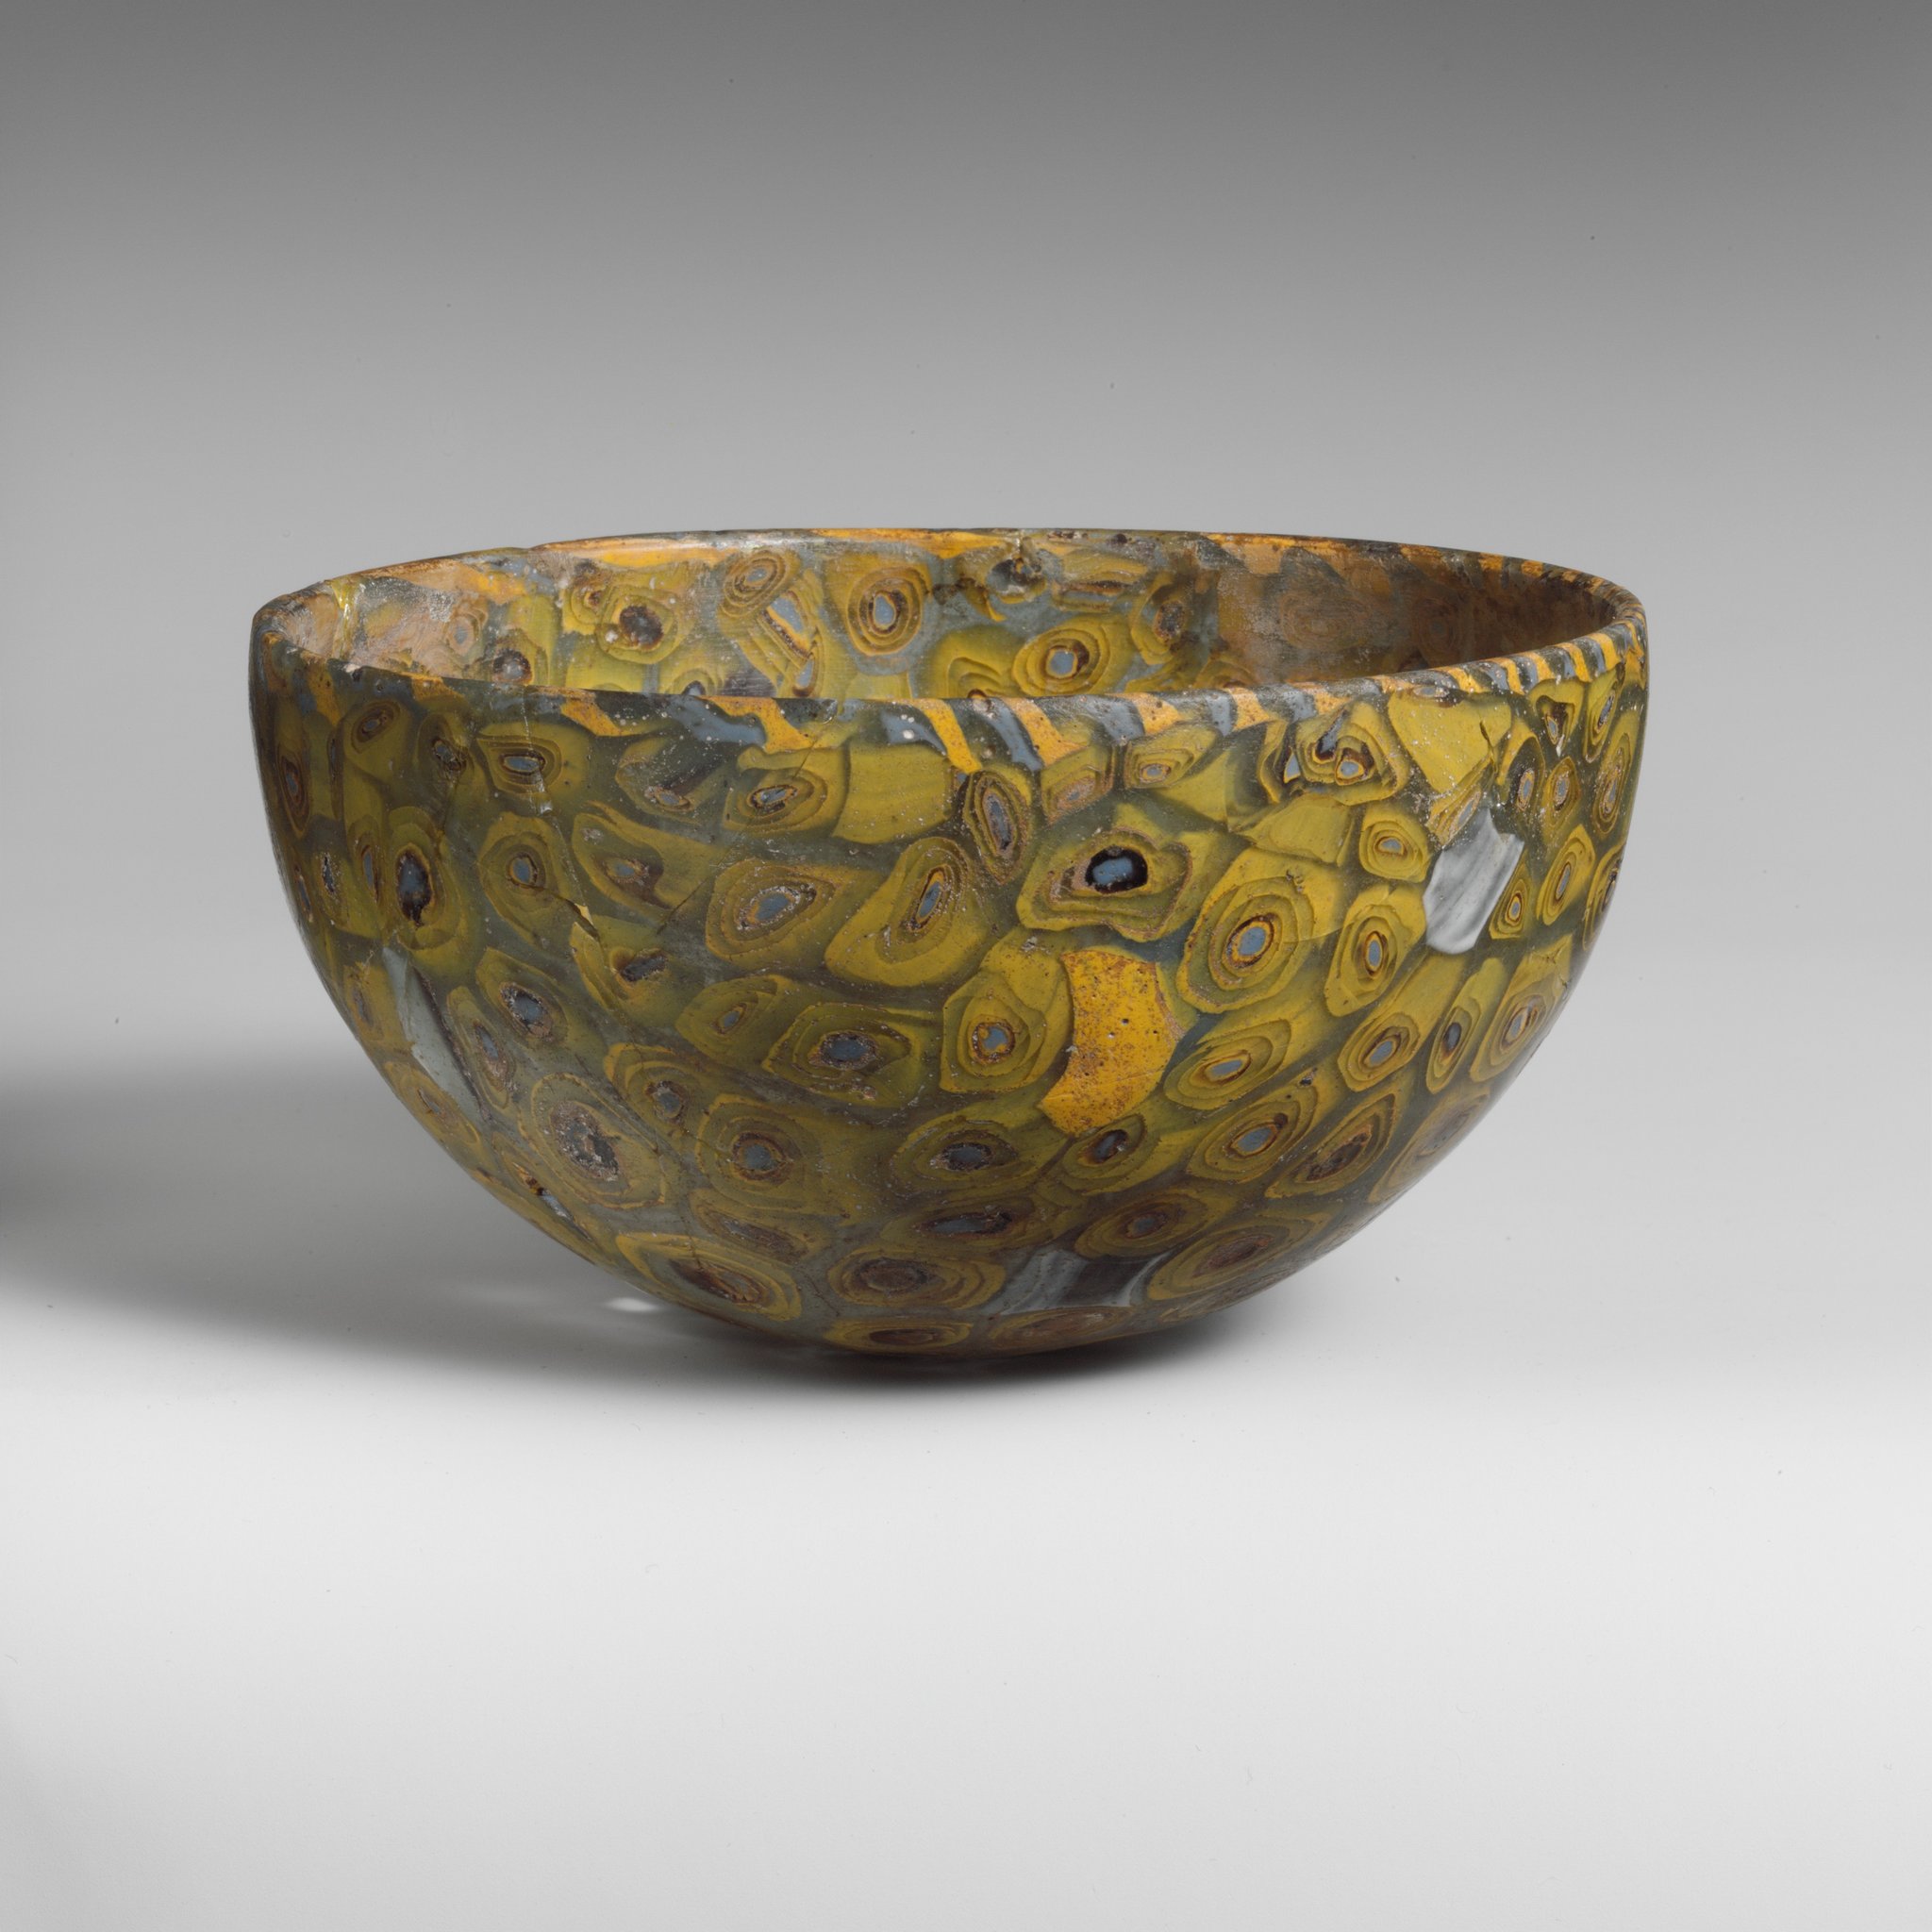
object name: bowl, mosaic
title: Glass mosaic hemispherical bowl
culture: greek, eastern mediterranean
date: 200-35 BCE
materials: glass